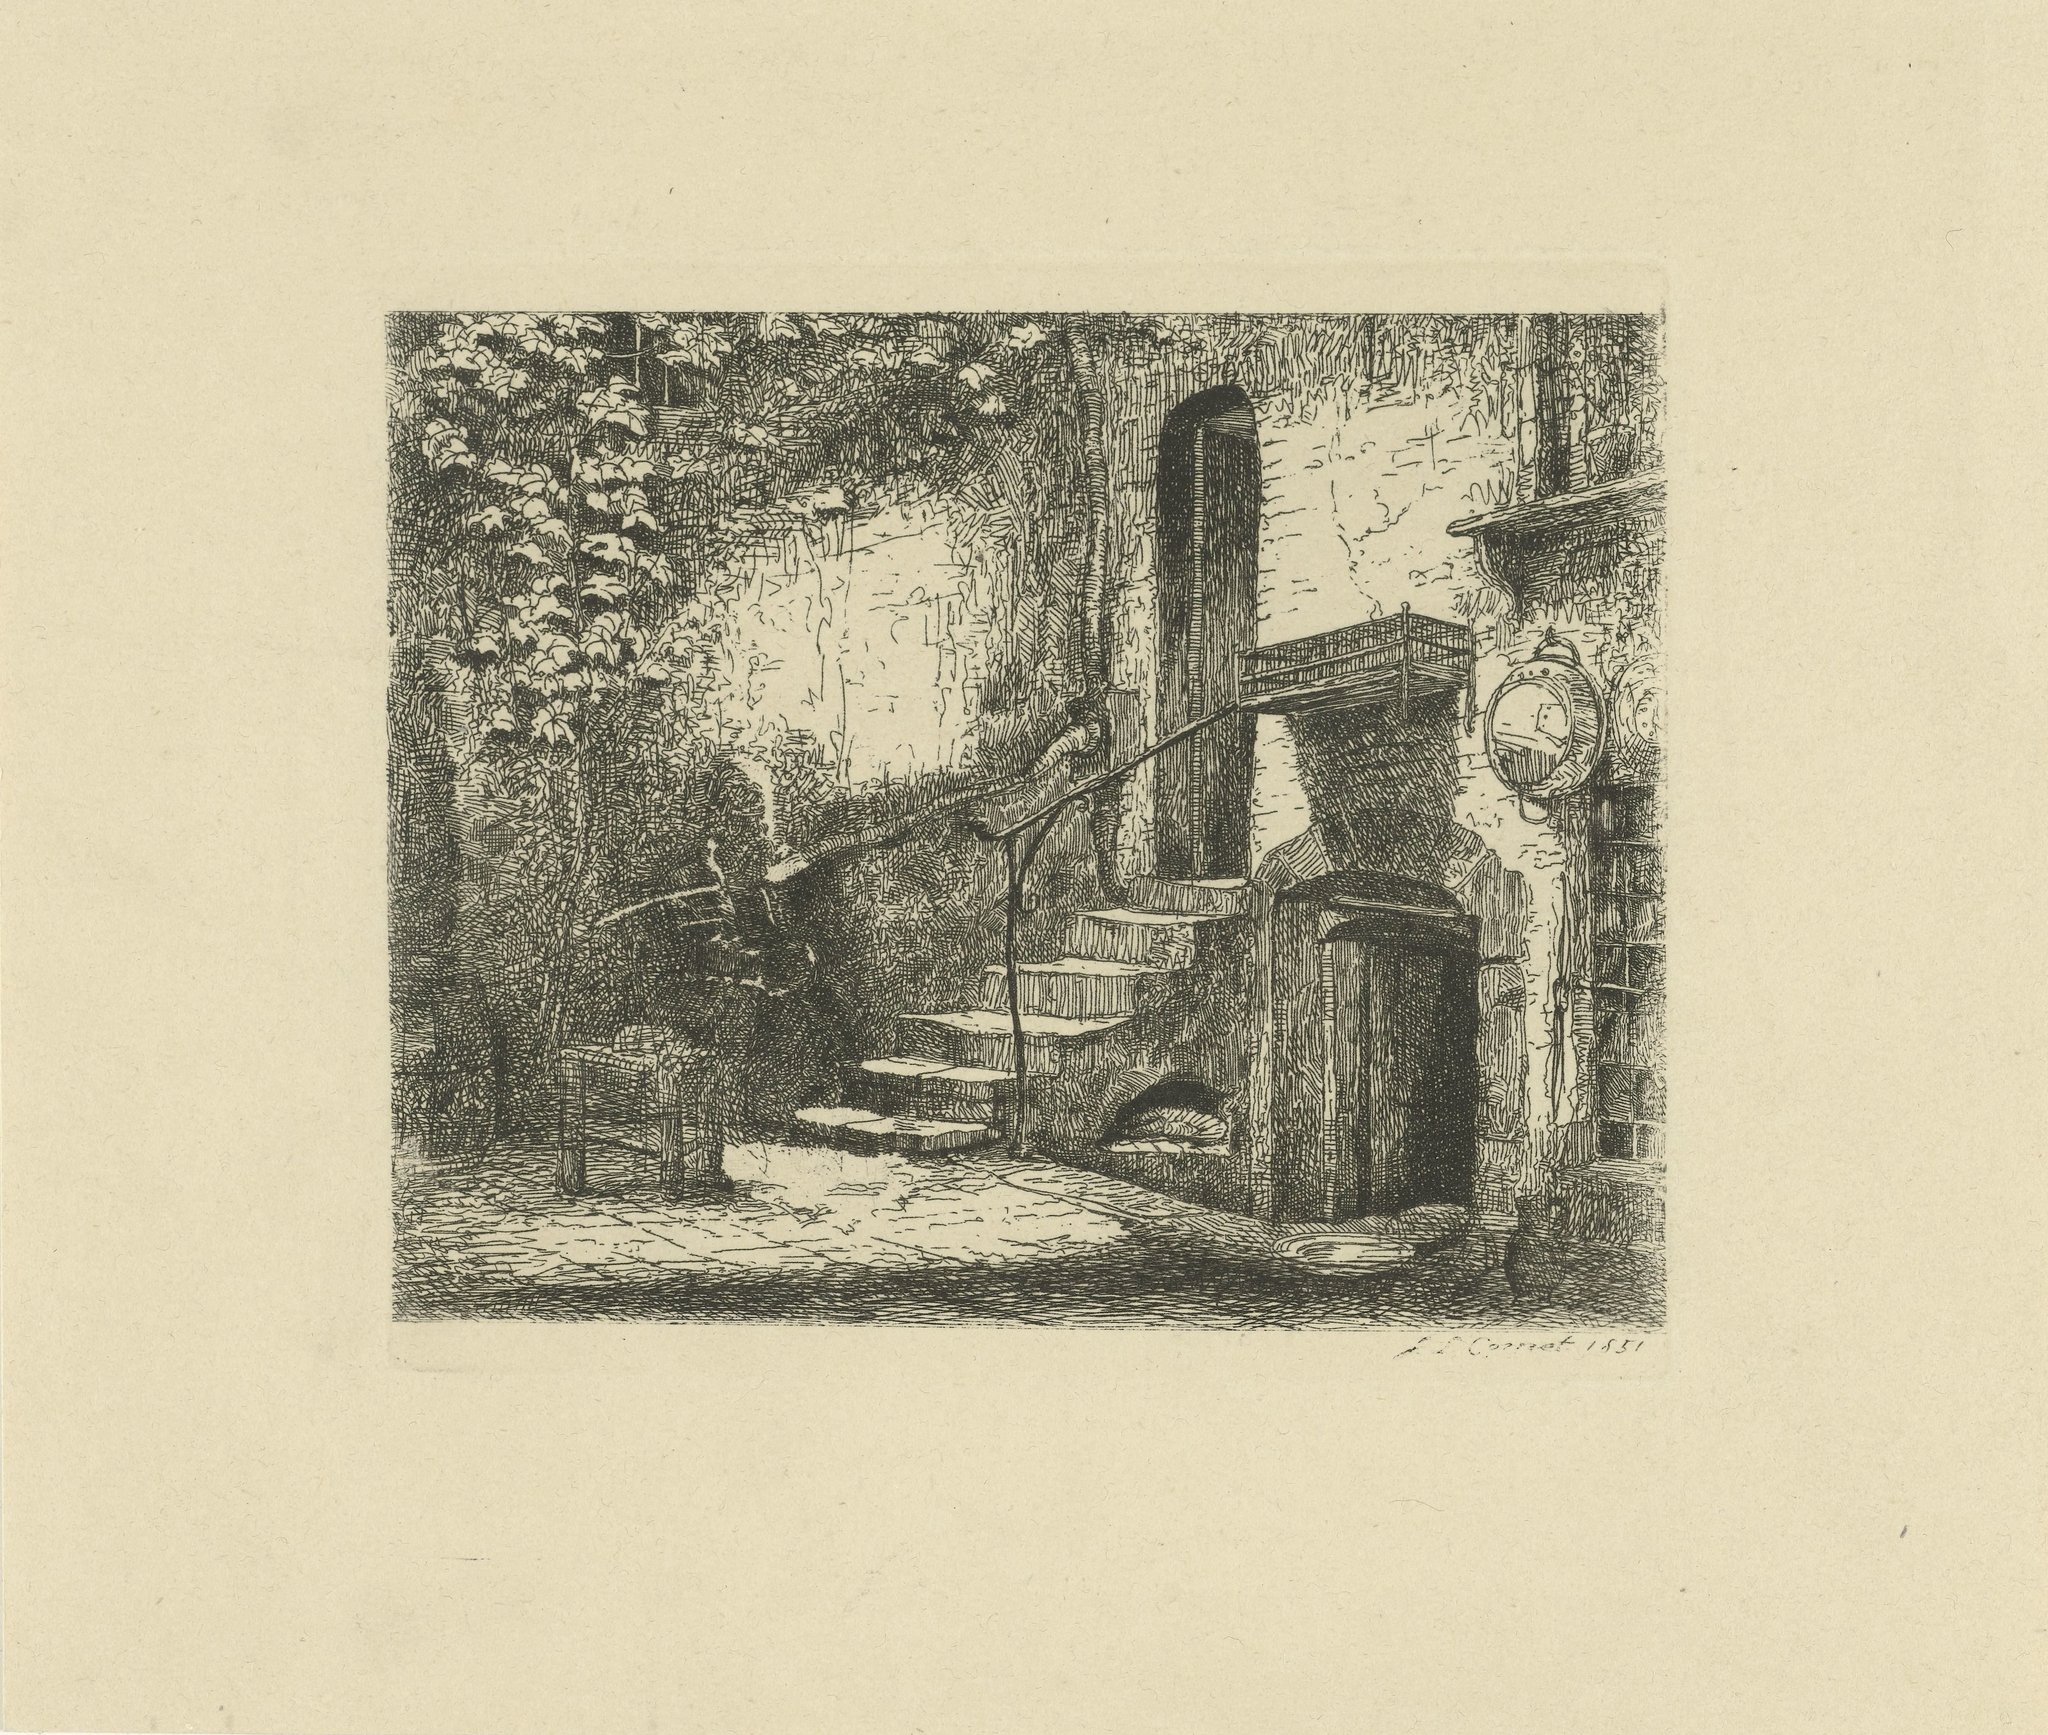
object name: print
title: Binnenplaats met trap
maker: jacobus ludovicus cornet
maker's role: draughtsman, print maker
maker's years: 1815-1882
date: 1851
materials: paper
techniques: etching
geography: haarlem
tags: courtyard, basement, cellar, plants and herbs: ivy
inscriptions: collector's mark: Lugt 2228, collector's mark: Lugt 2760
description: Een binnenplaats met trap voor de ingang. Rechts onder een kelder met openstaande deur. Een wingerd groeit tegen de muur.